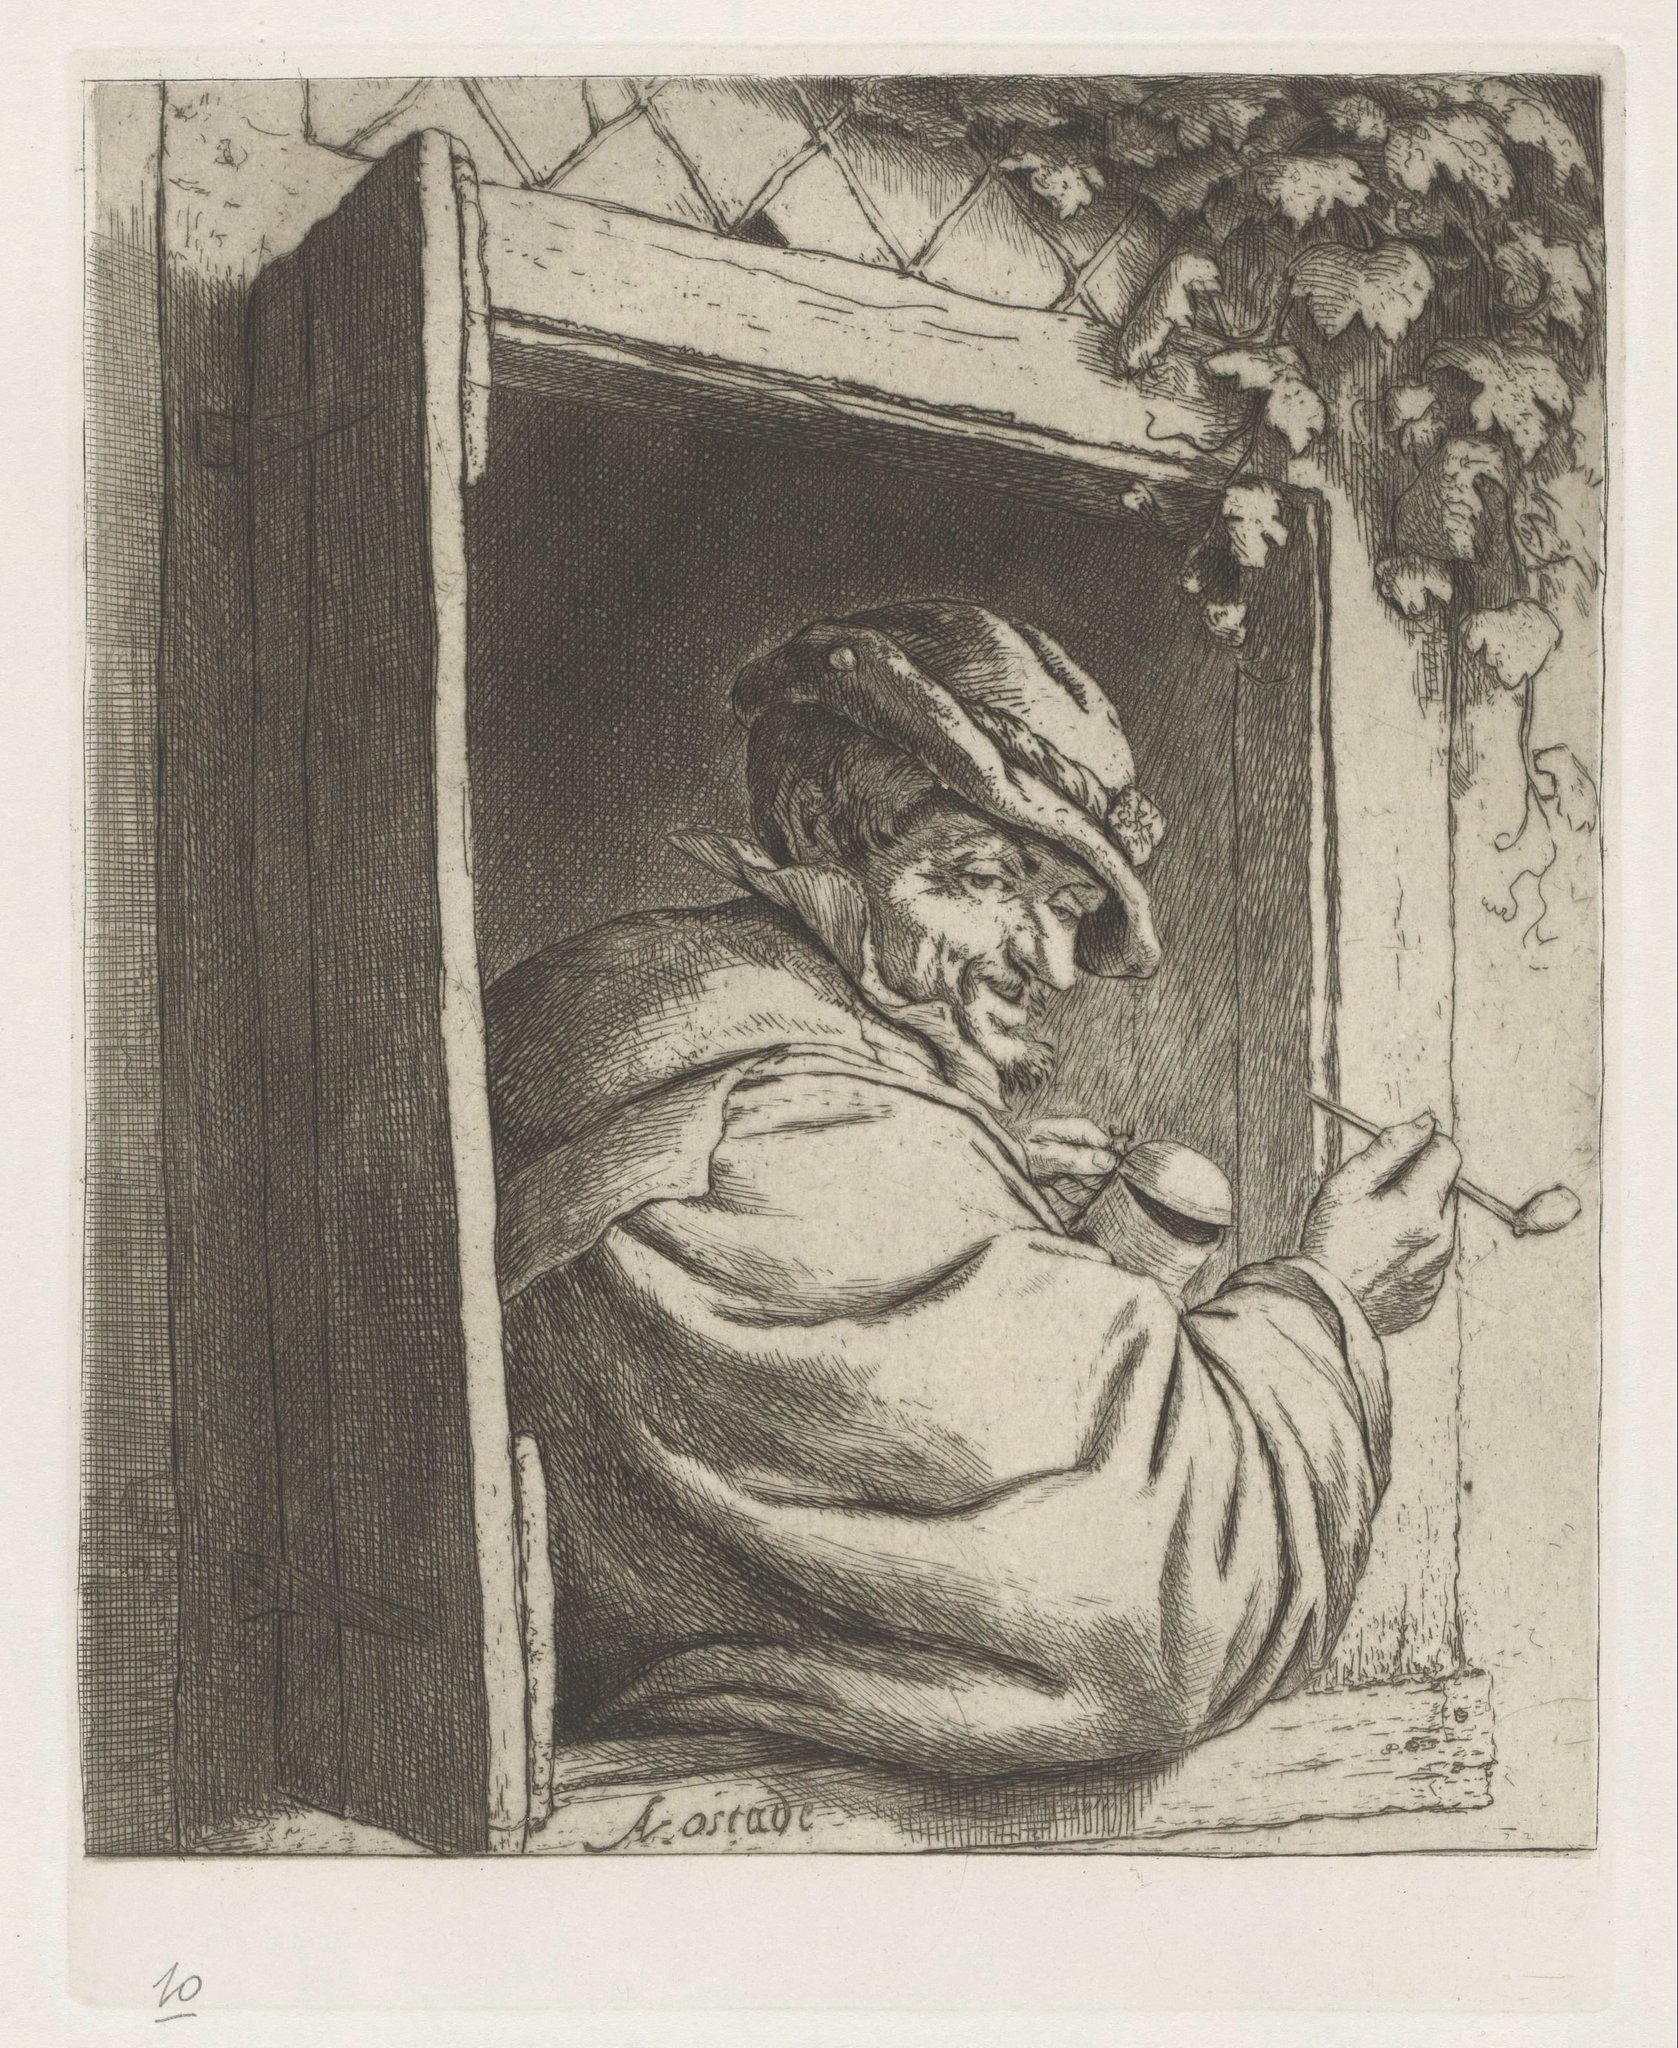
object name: print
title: Rokende boer in een raamopening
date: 1648-1650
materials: paper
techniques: etching, galvanization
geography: haarlem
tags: window, pipe ~ tobacco, male sex; man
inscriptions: collector's mark: ‘RIJKS / MUSM’, collector's mark: ‘B’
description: Boer of man met pijp en drinkbeker in een raamopening met een naar buiten openslaand luik. De prent maakt deel uit van een portefeuille.